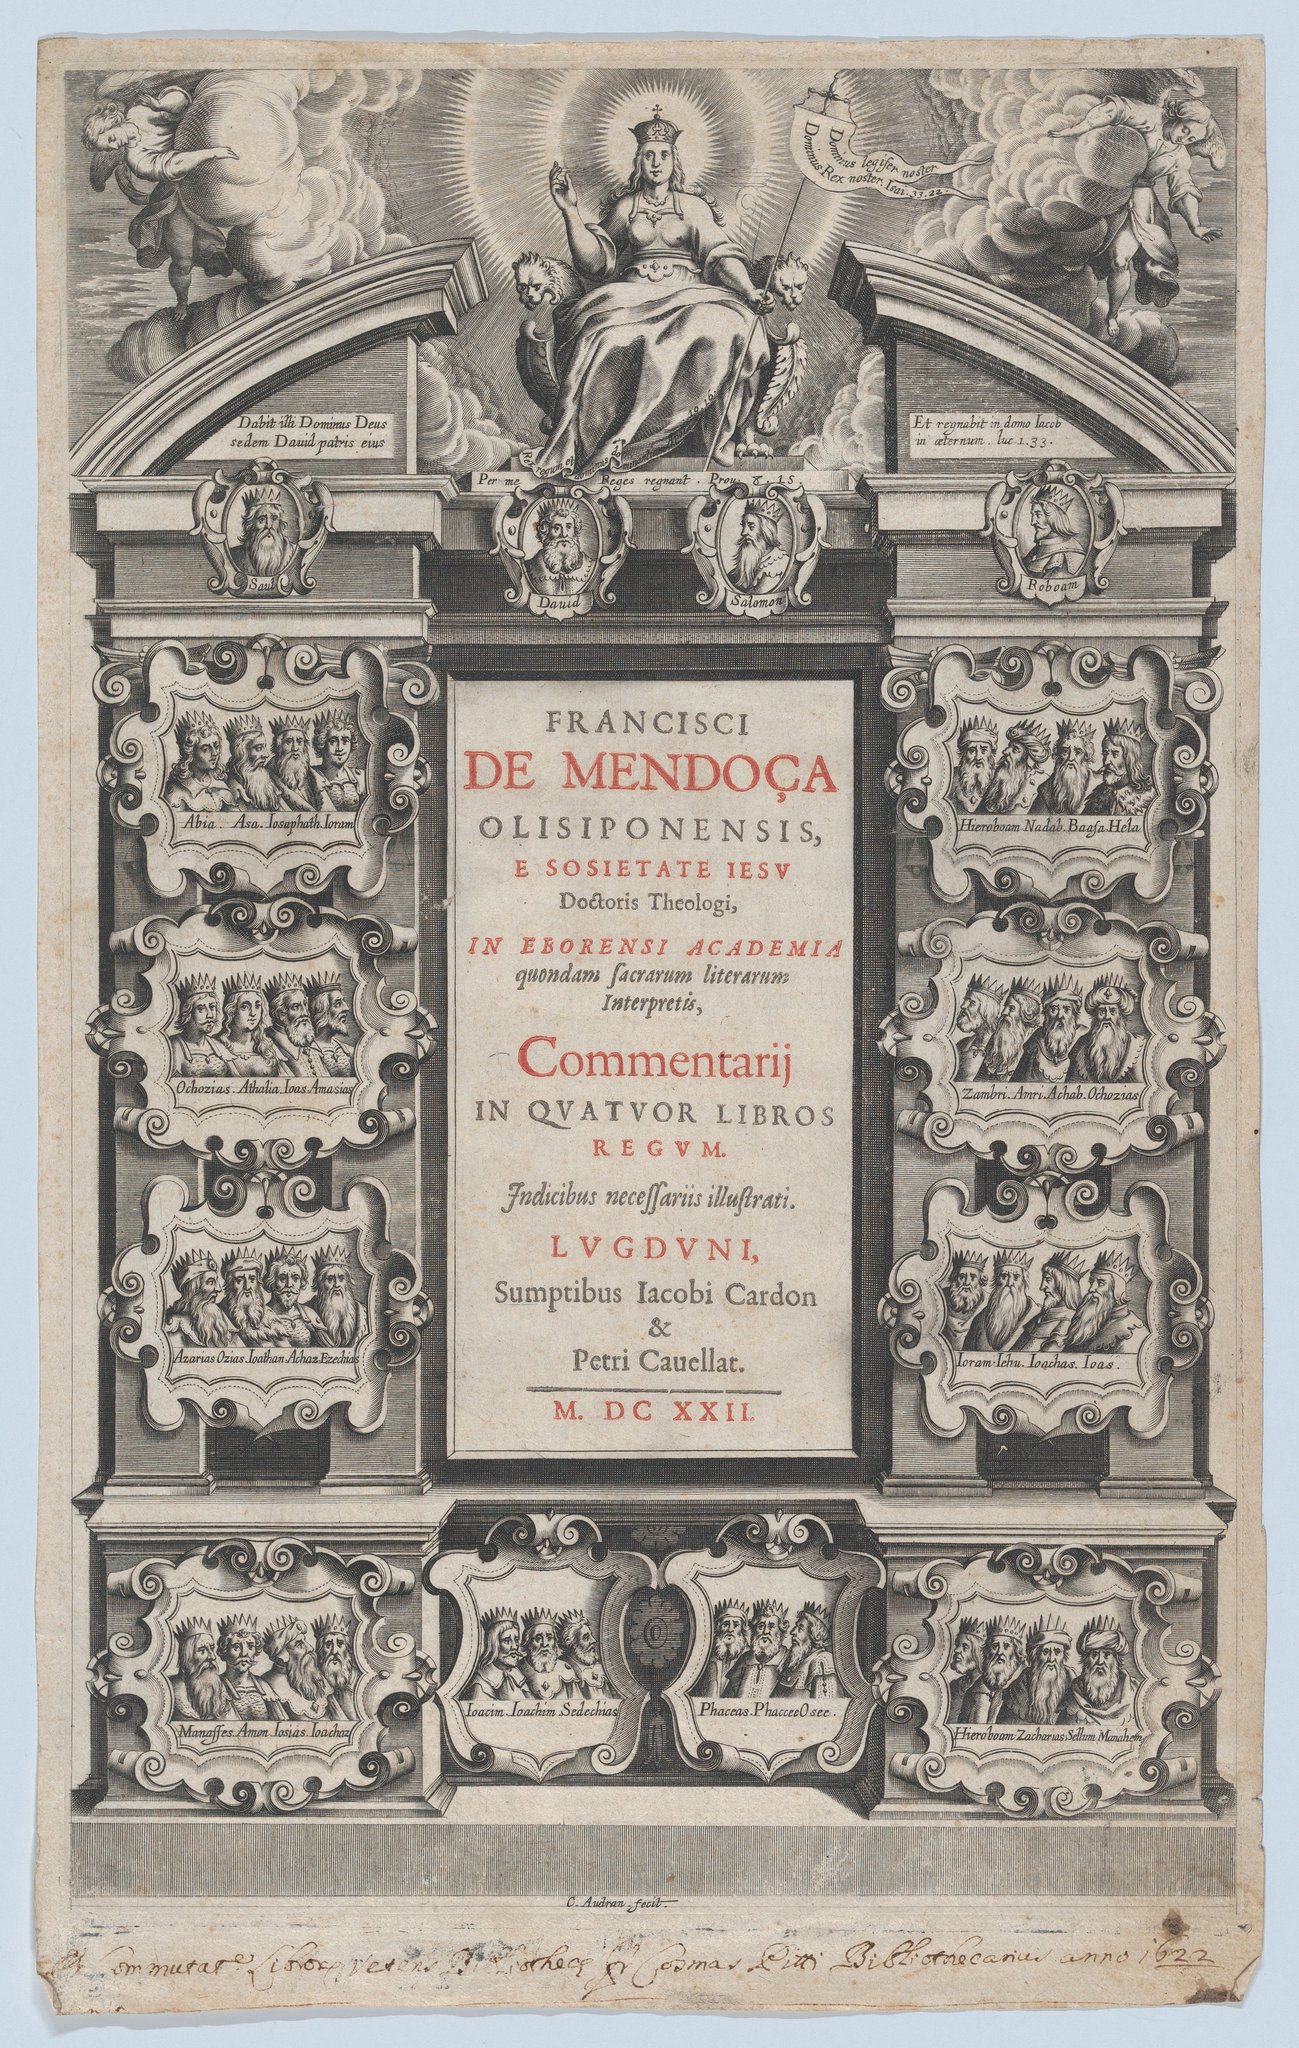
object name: print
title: Frontispiece for Commentarij in Quator Libros Regum by F. de Monoça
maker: charles audran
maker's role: artist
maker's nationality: french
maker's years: 1594-1674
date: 1622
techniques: etching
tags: men,portraits,goddess